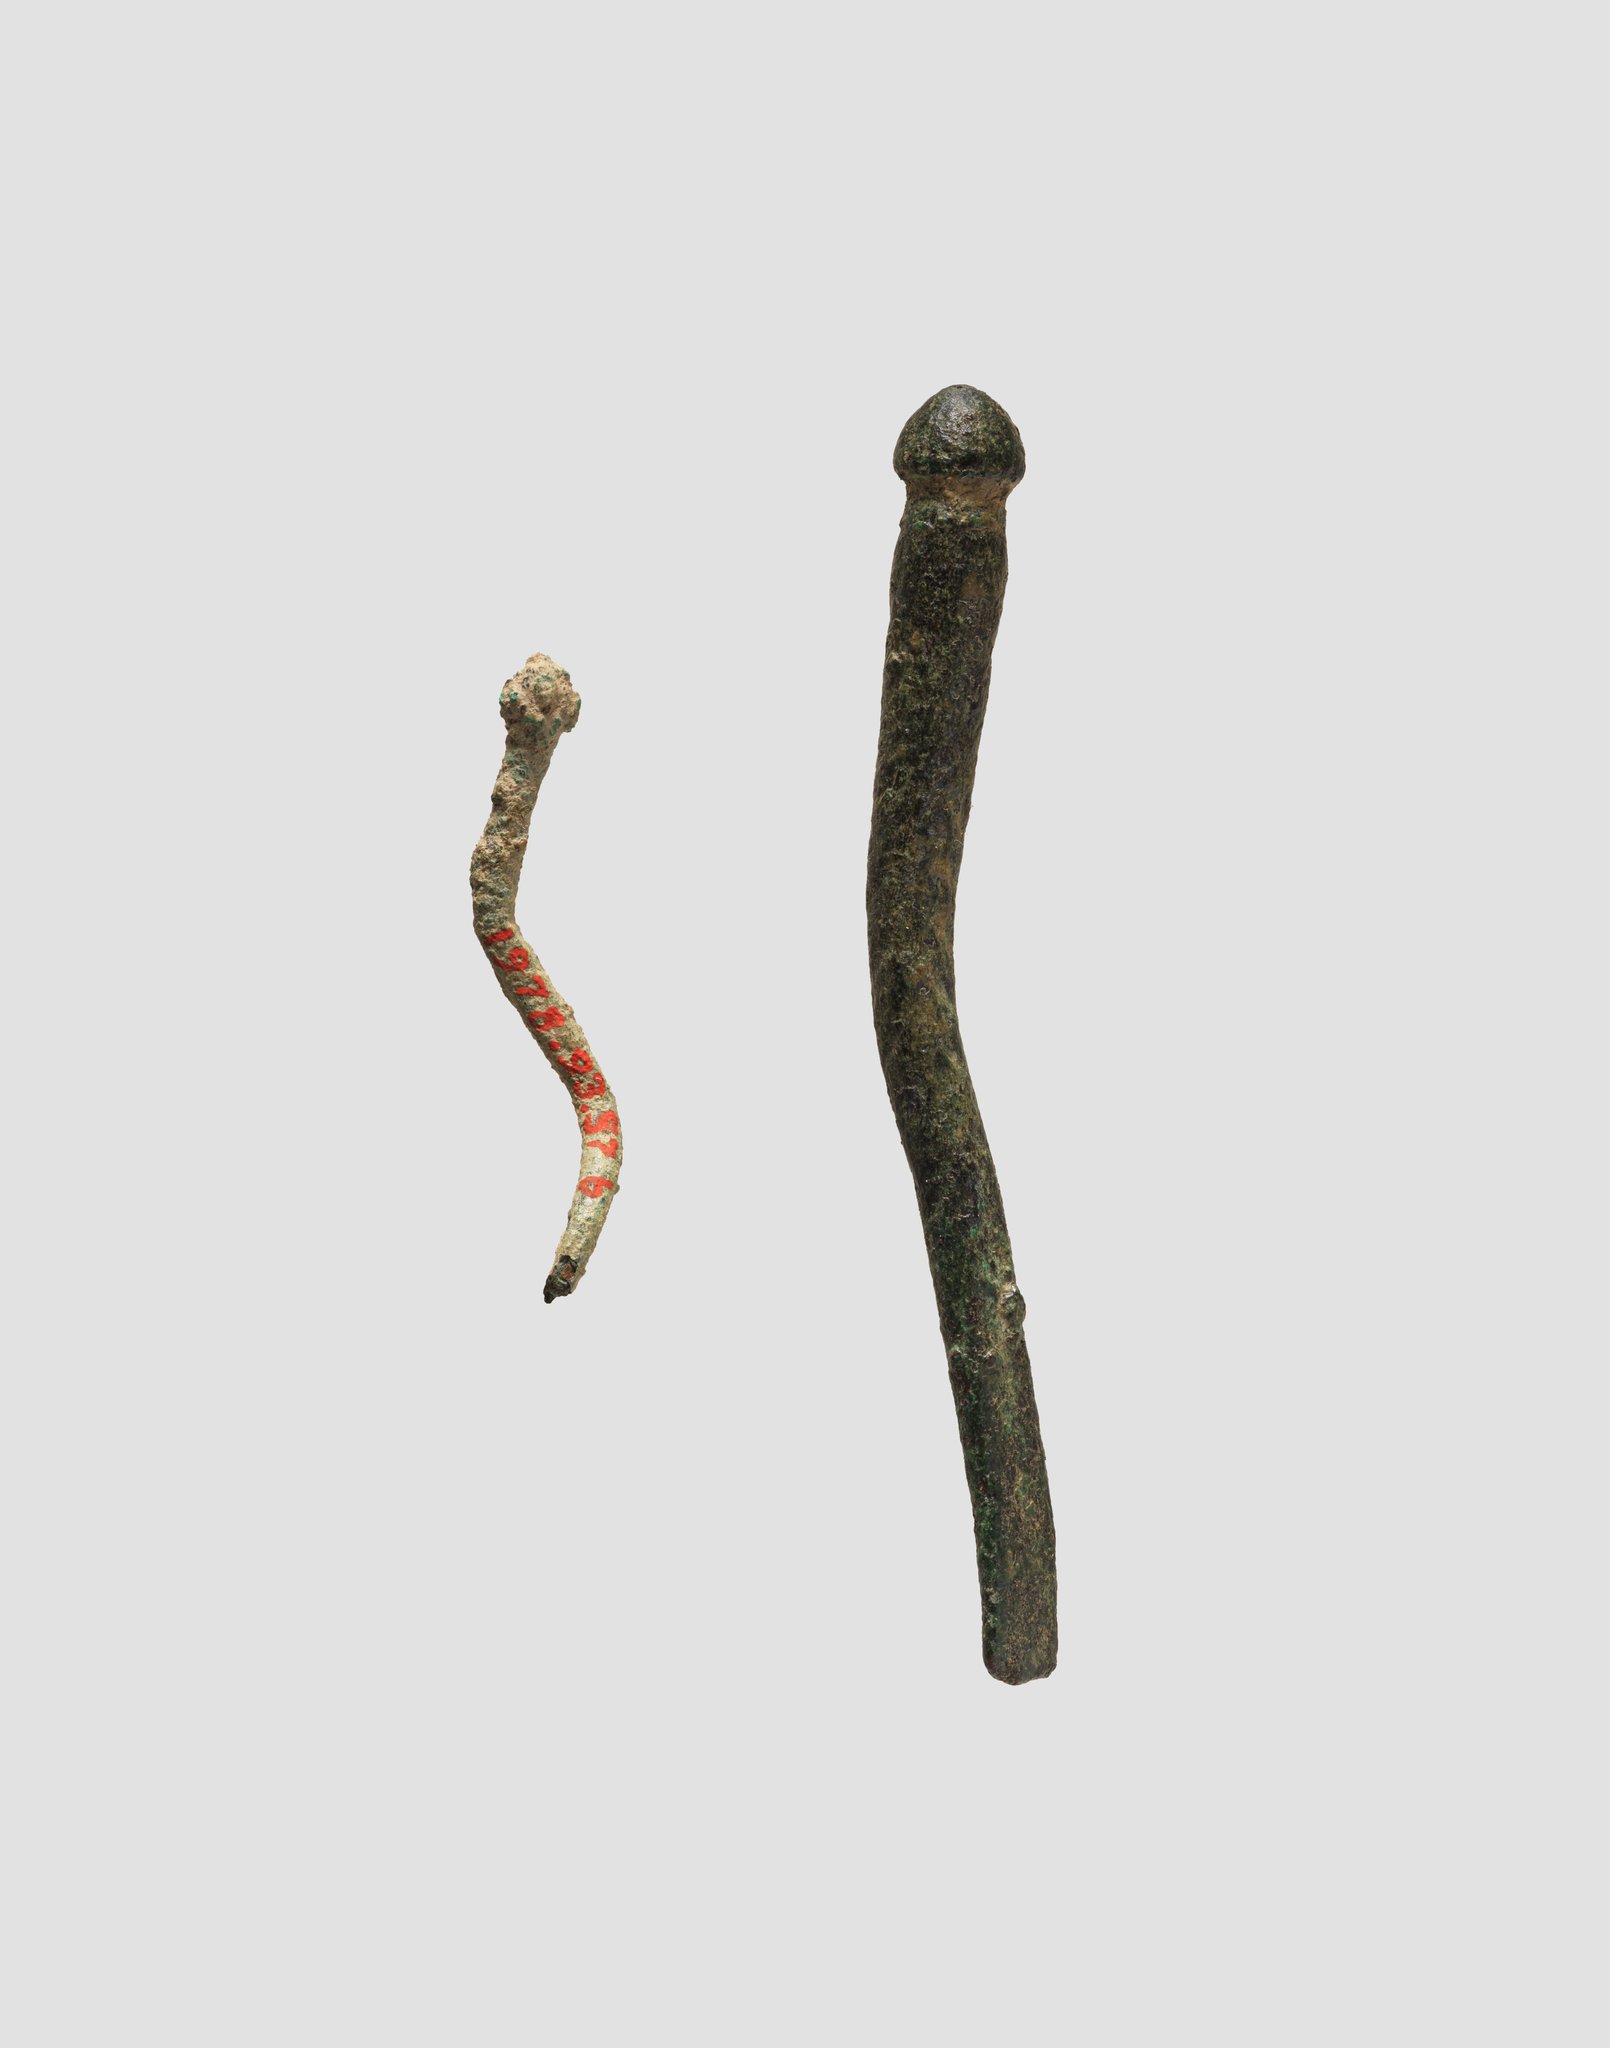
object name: pin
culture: parthian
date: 1-100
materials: bronze, copper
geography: iran